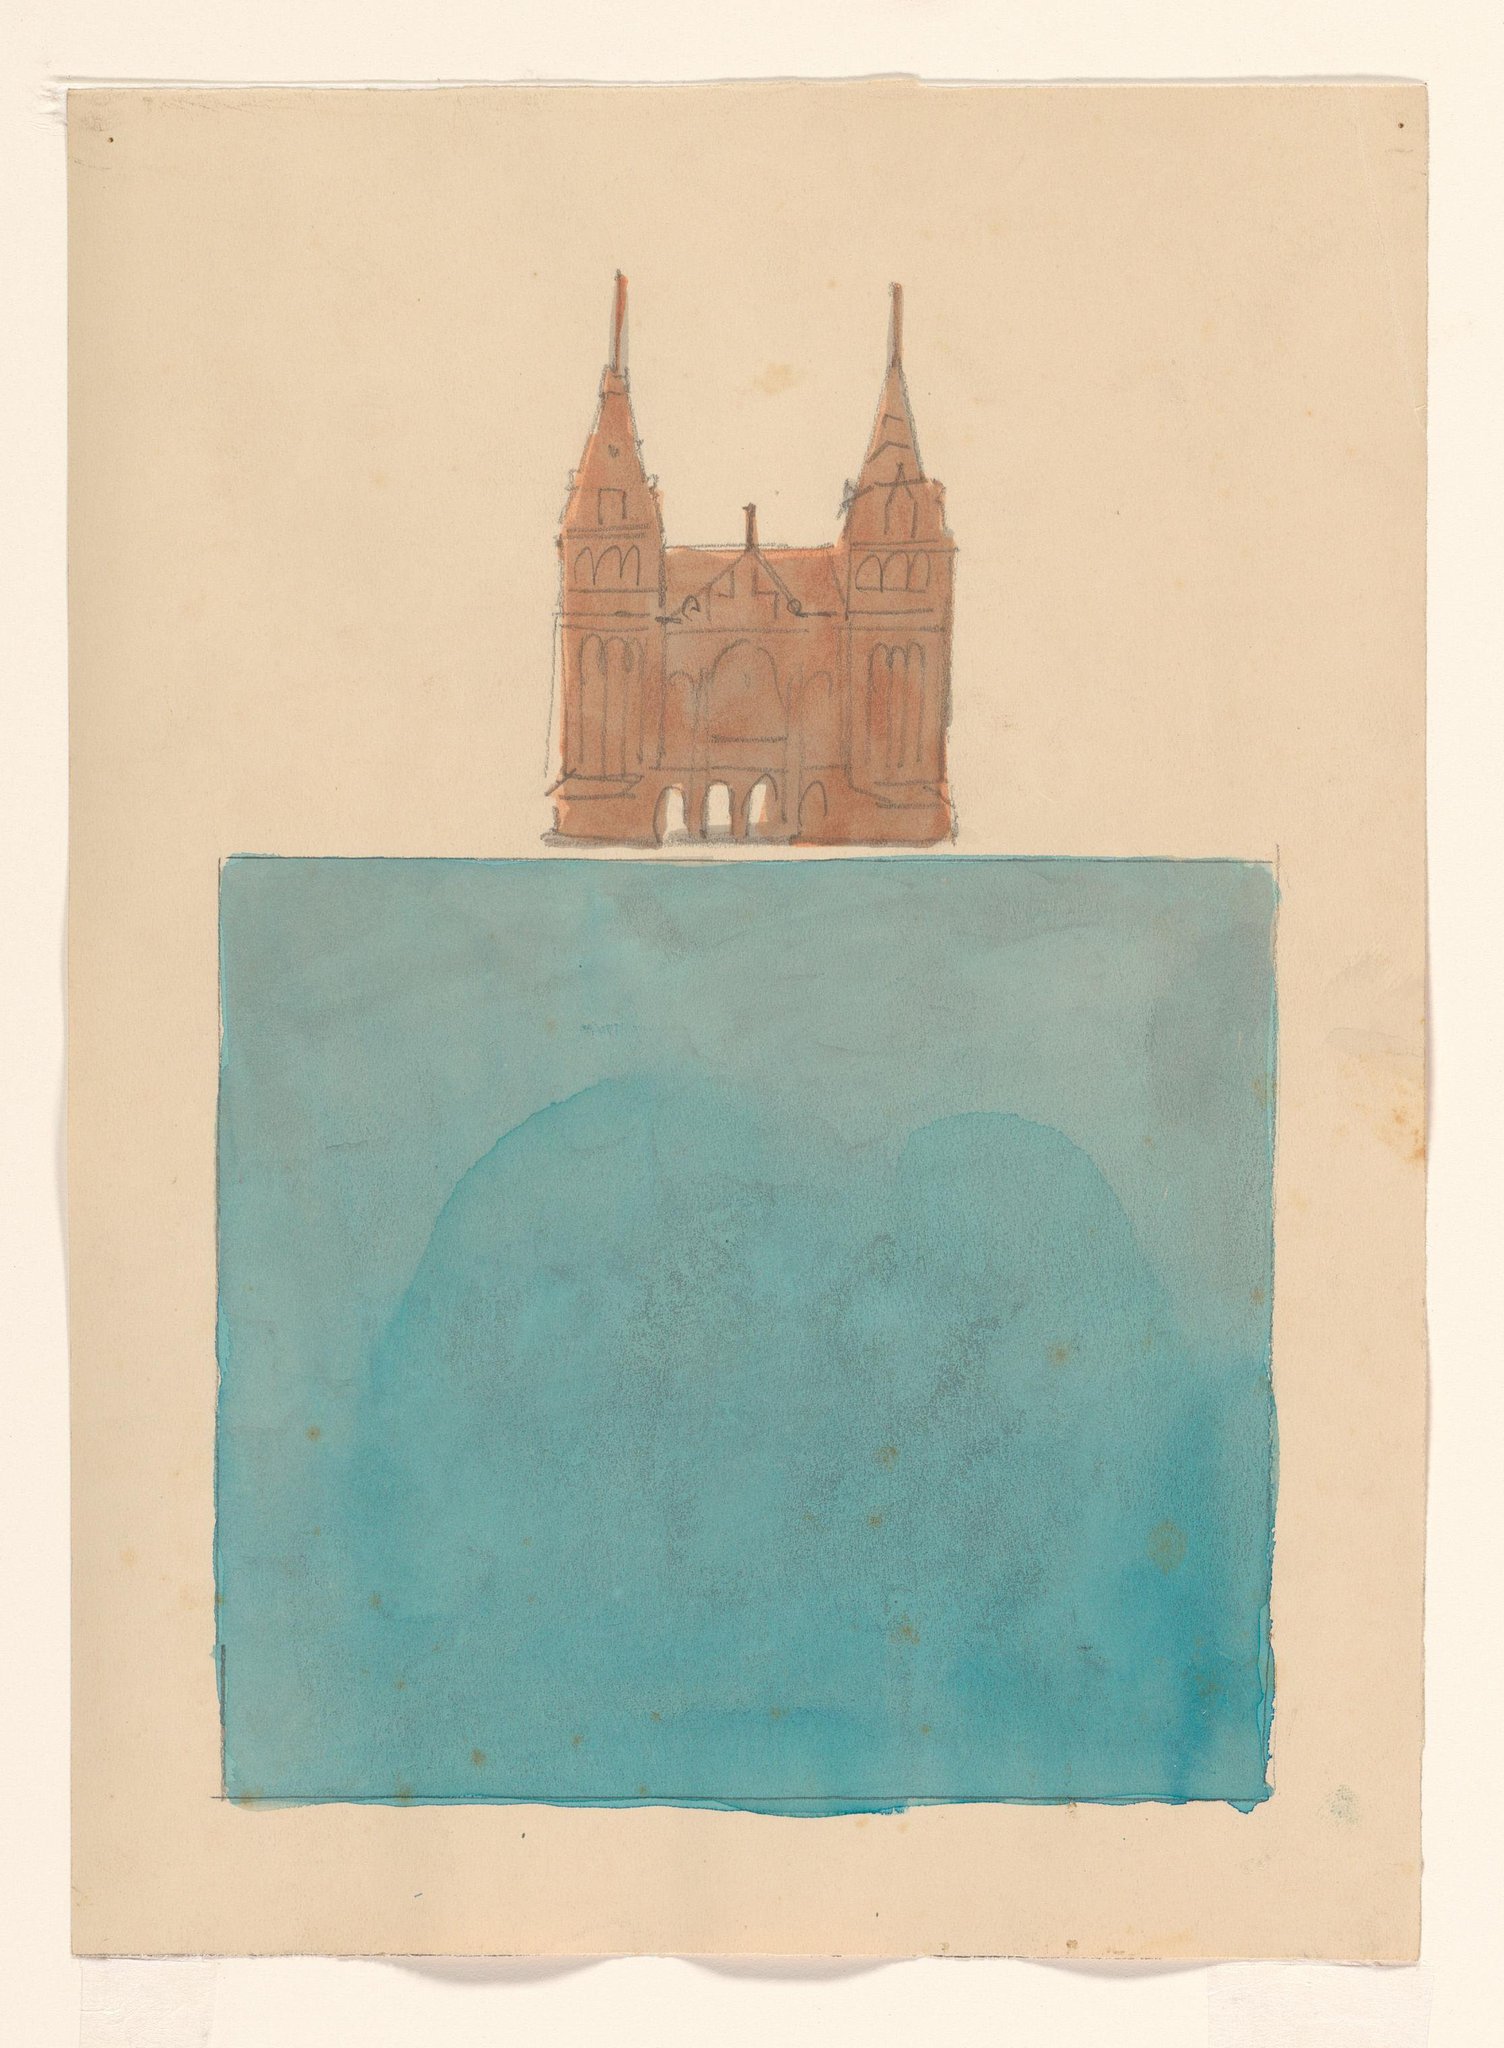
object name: drawing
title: Gezicht op het Rijksmuseum, zijde Stadhouderskade, boven een blauw vlak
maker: Anonymous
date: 1900-1999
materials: paper, pencil, watercolor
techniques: brush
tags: permanent exhibition, museum